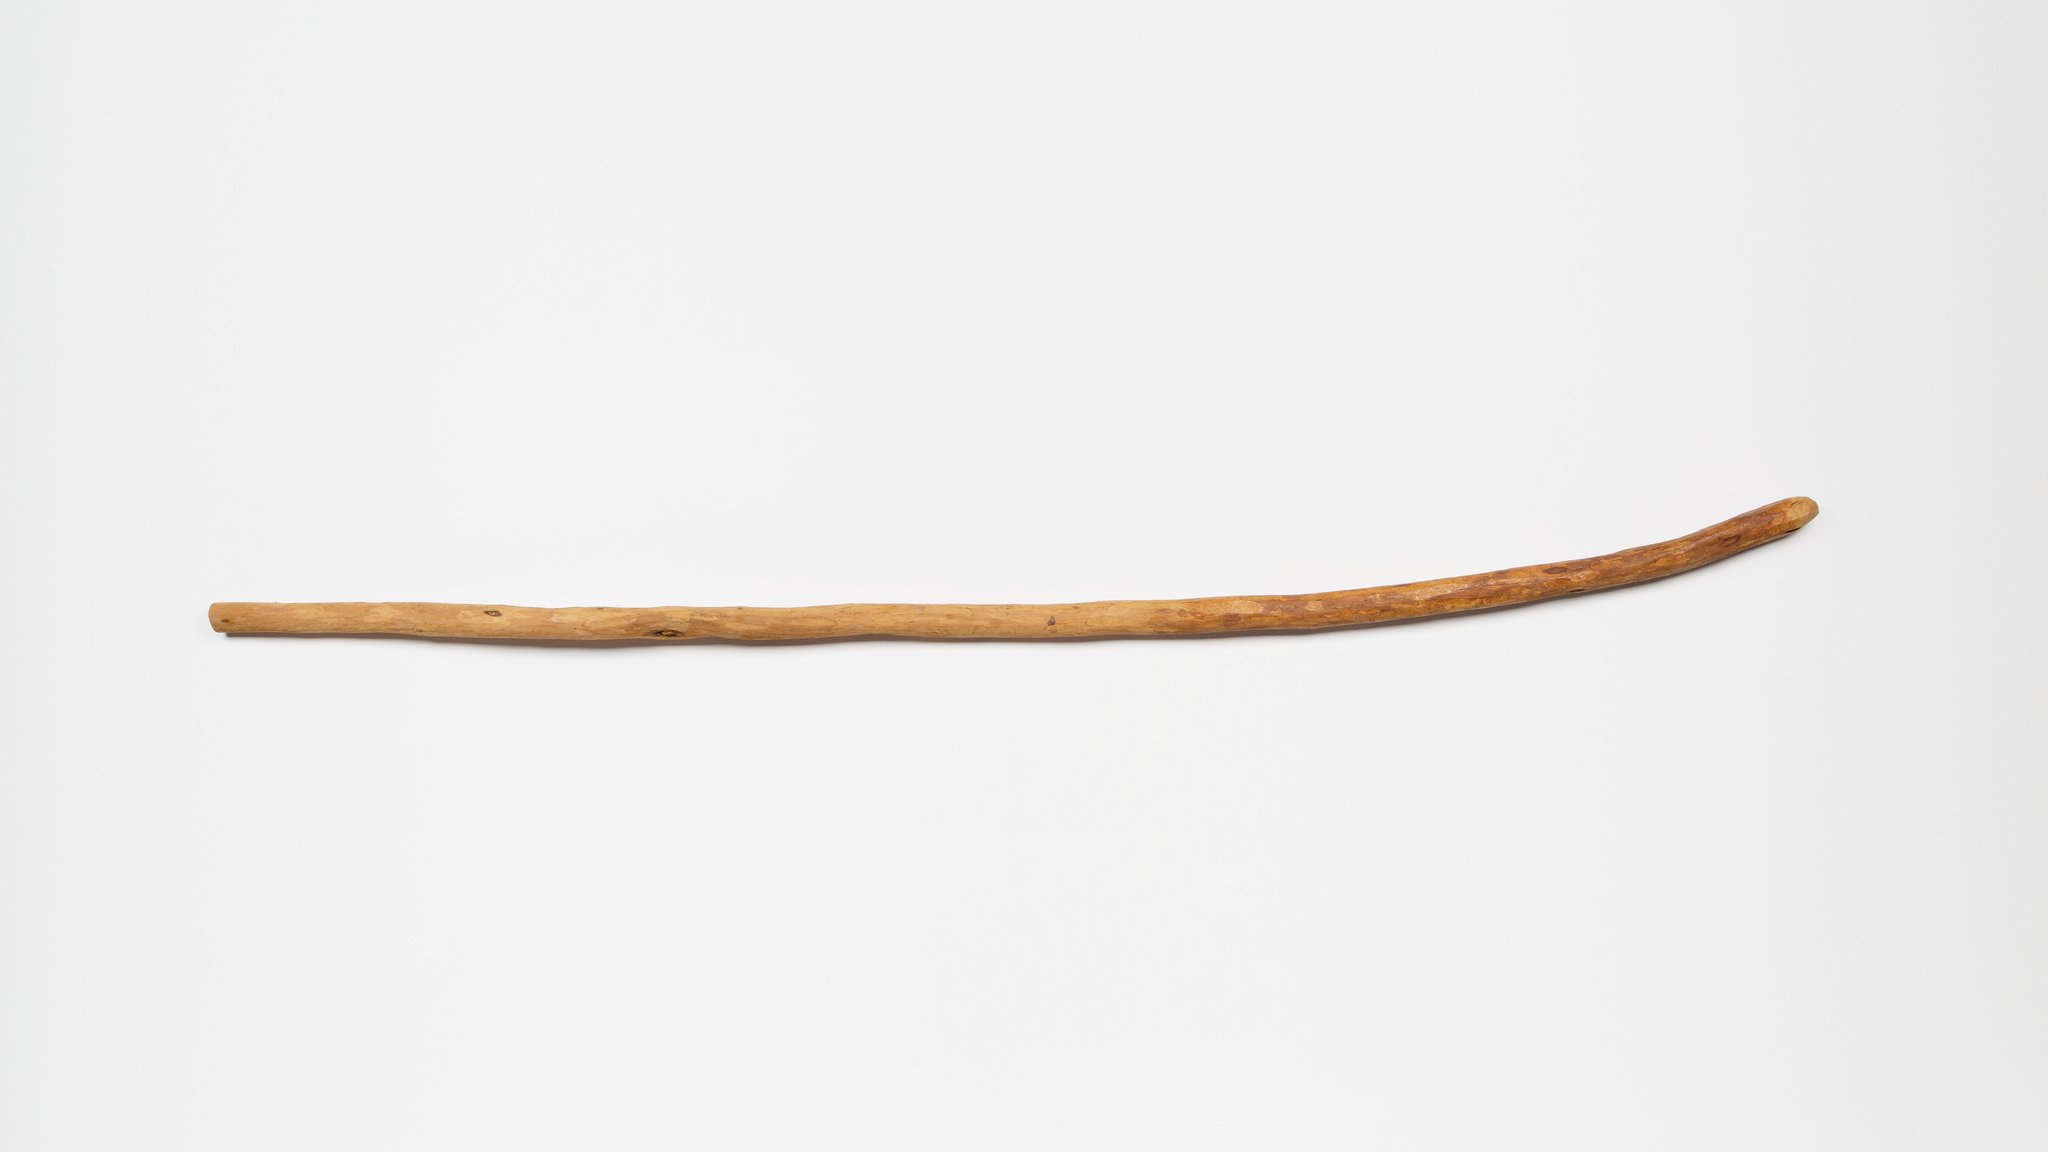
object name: staff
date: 1981-1975 BCE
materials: wood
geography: egypt